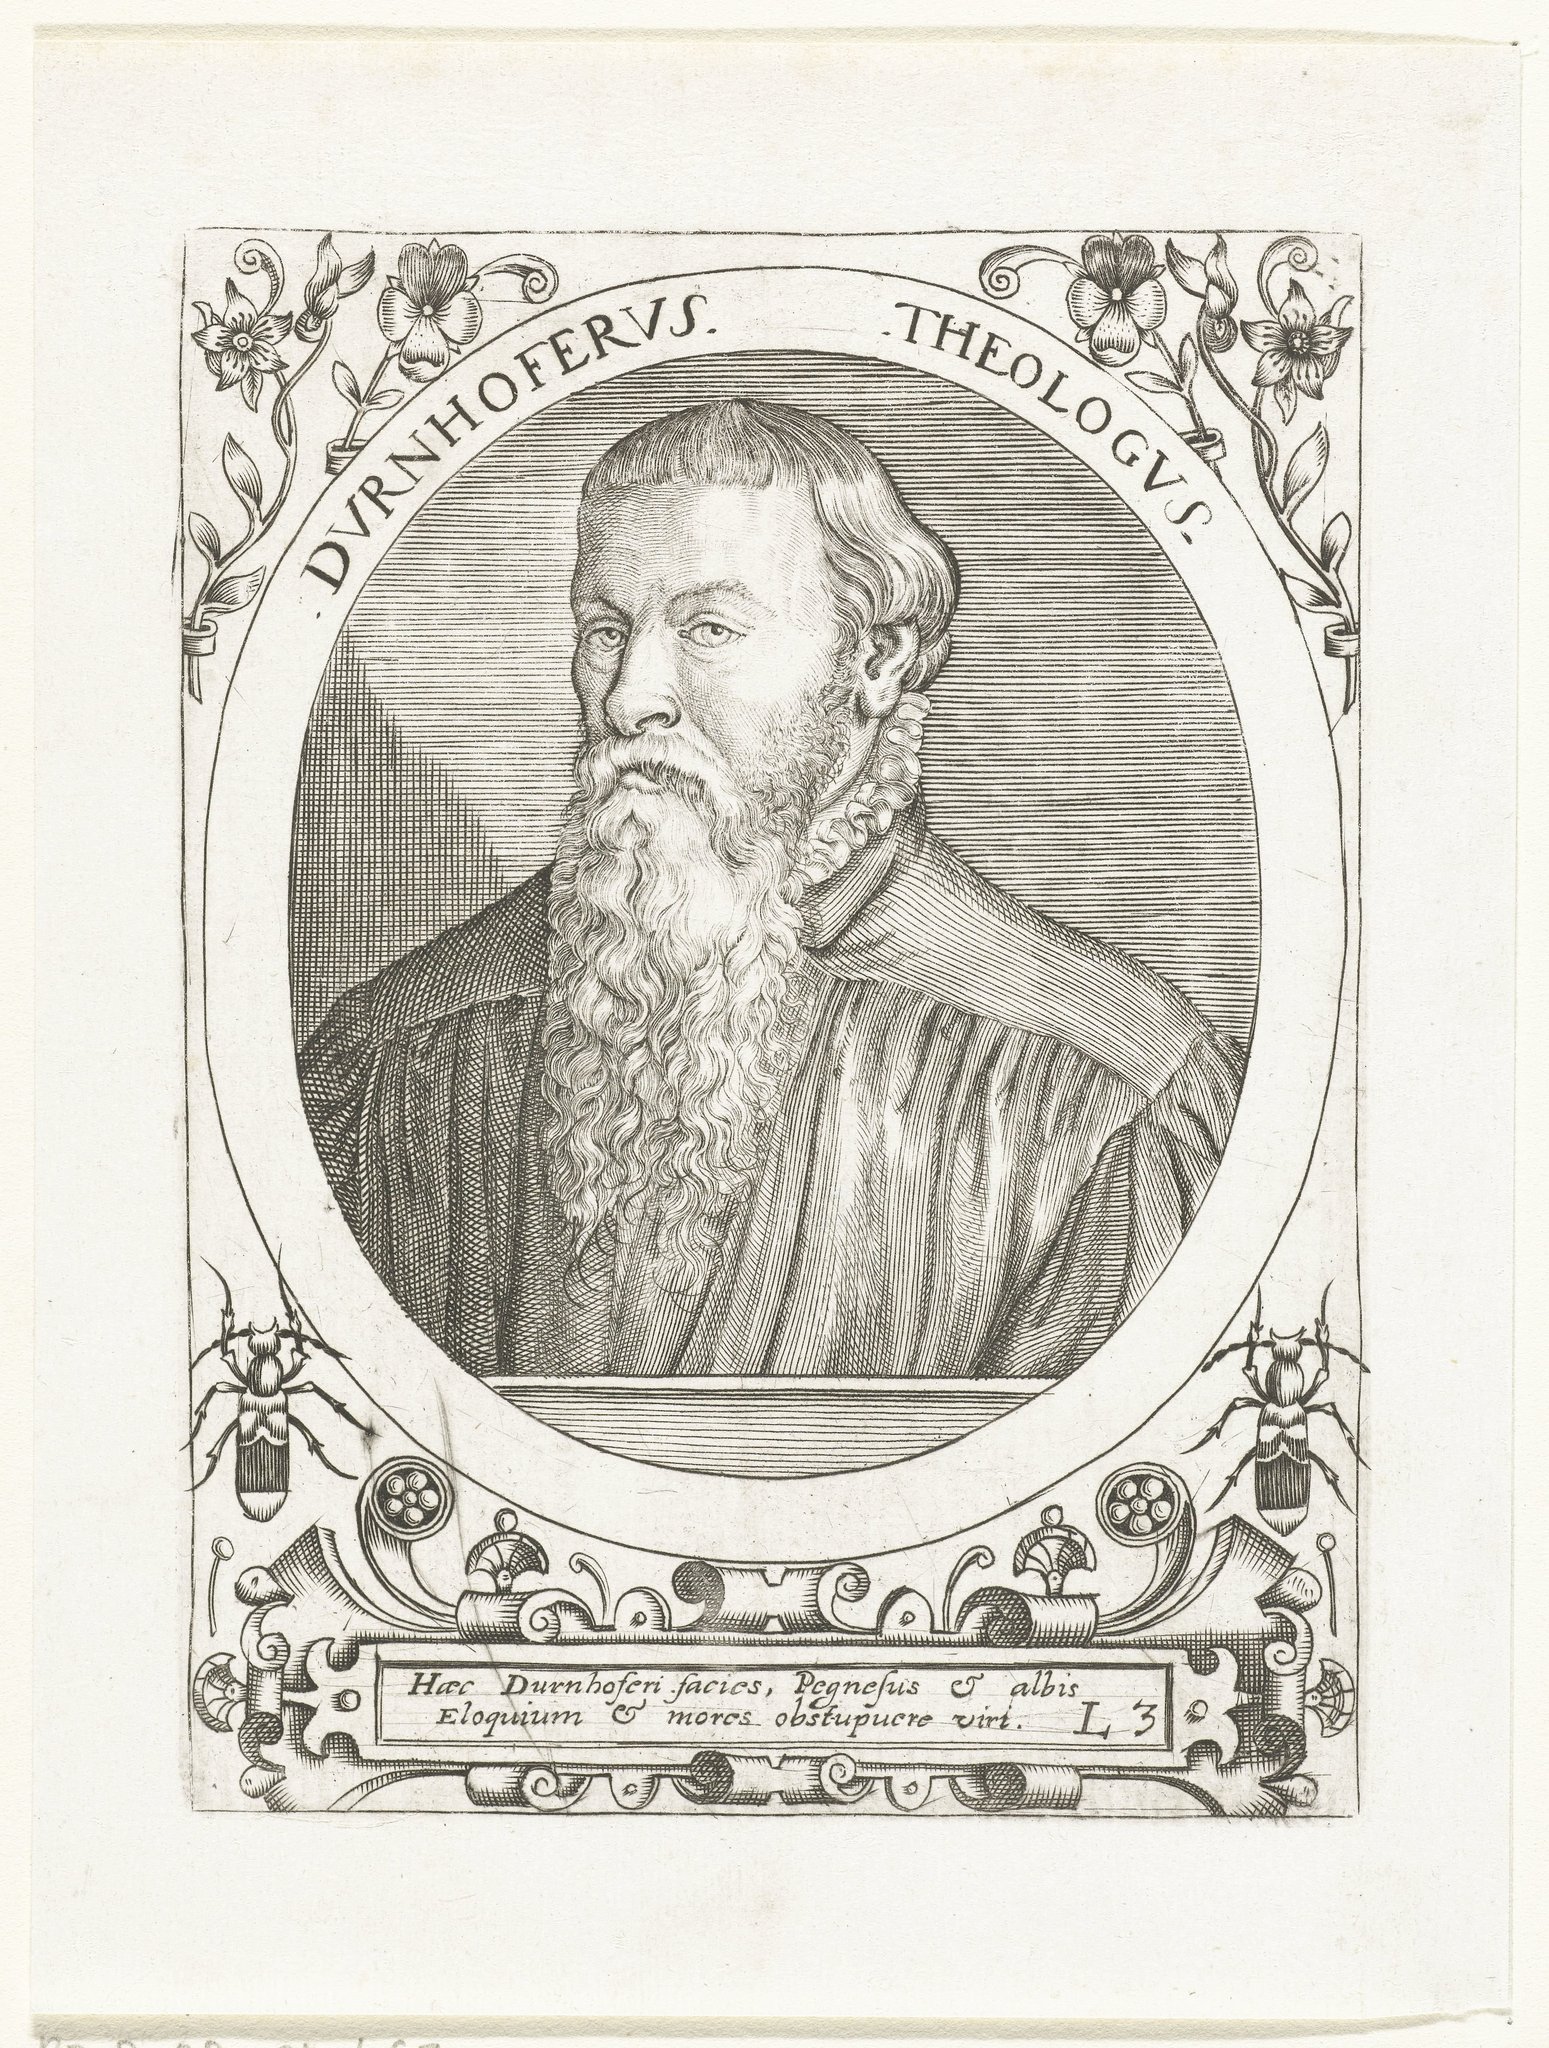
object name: book illustration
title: Portret van Lorenz Dürnhofer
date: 1669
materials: paper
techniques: engraving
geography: frankfurt am main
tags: durnhofer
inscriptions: collector's mark: Lugt 2228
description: Gemaakt voor: J.J. Boissard, Icones virorum illustrium doctrina &c eruditione praestanti um contines. Frankfurt am Main: de Bry, 1597-1599. Opnieuw gebruikt in: J.J.Boissard, Bibliotheca chalcographica, hoc est Virtute et eruditione clarorum Virorum Imagines. Heidelberg: Clemens Ammon, 1669. Dl. 1-5 (te herkennen aan de toegevoegde signatuur in de rechter onderhoek: L3).